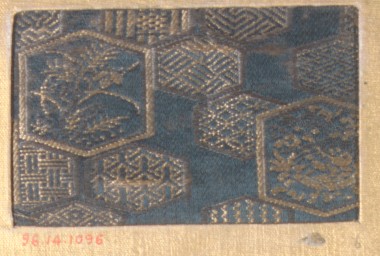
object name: piece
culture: japanese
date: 1701-1900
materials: silk